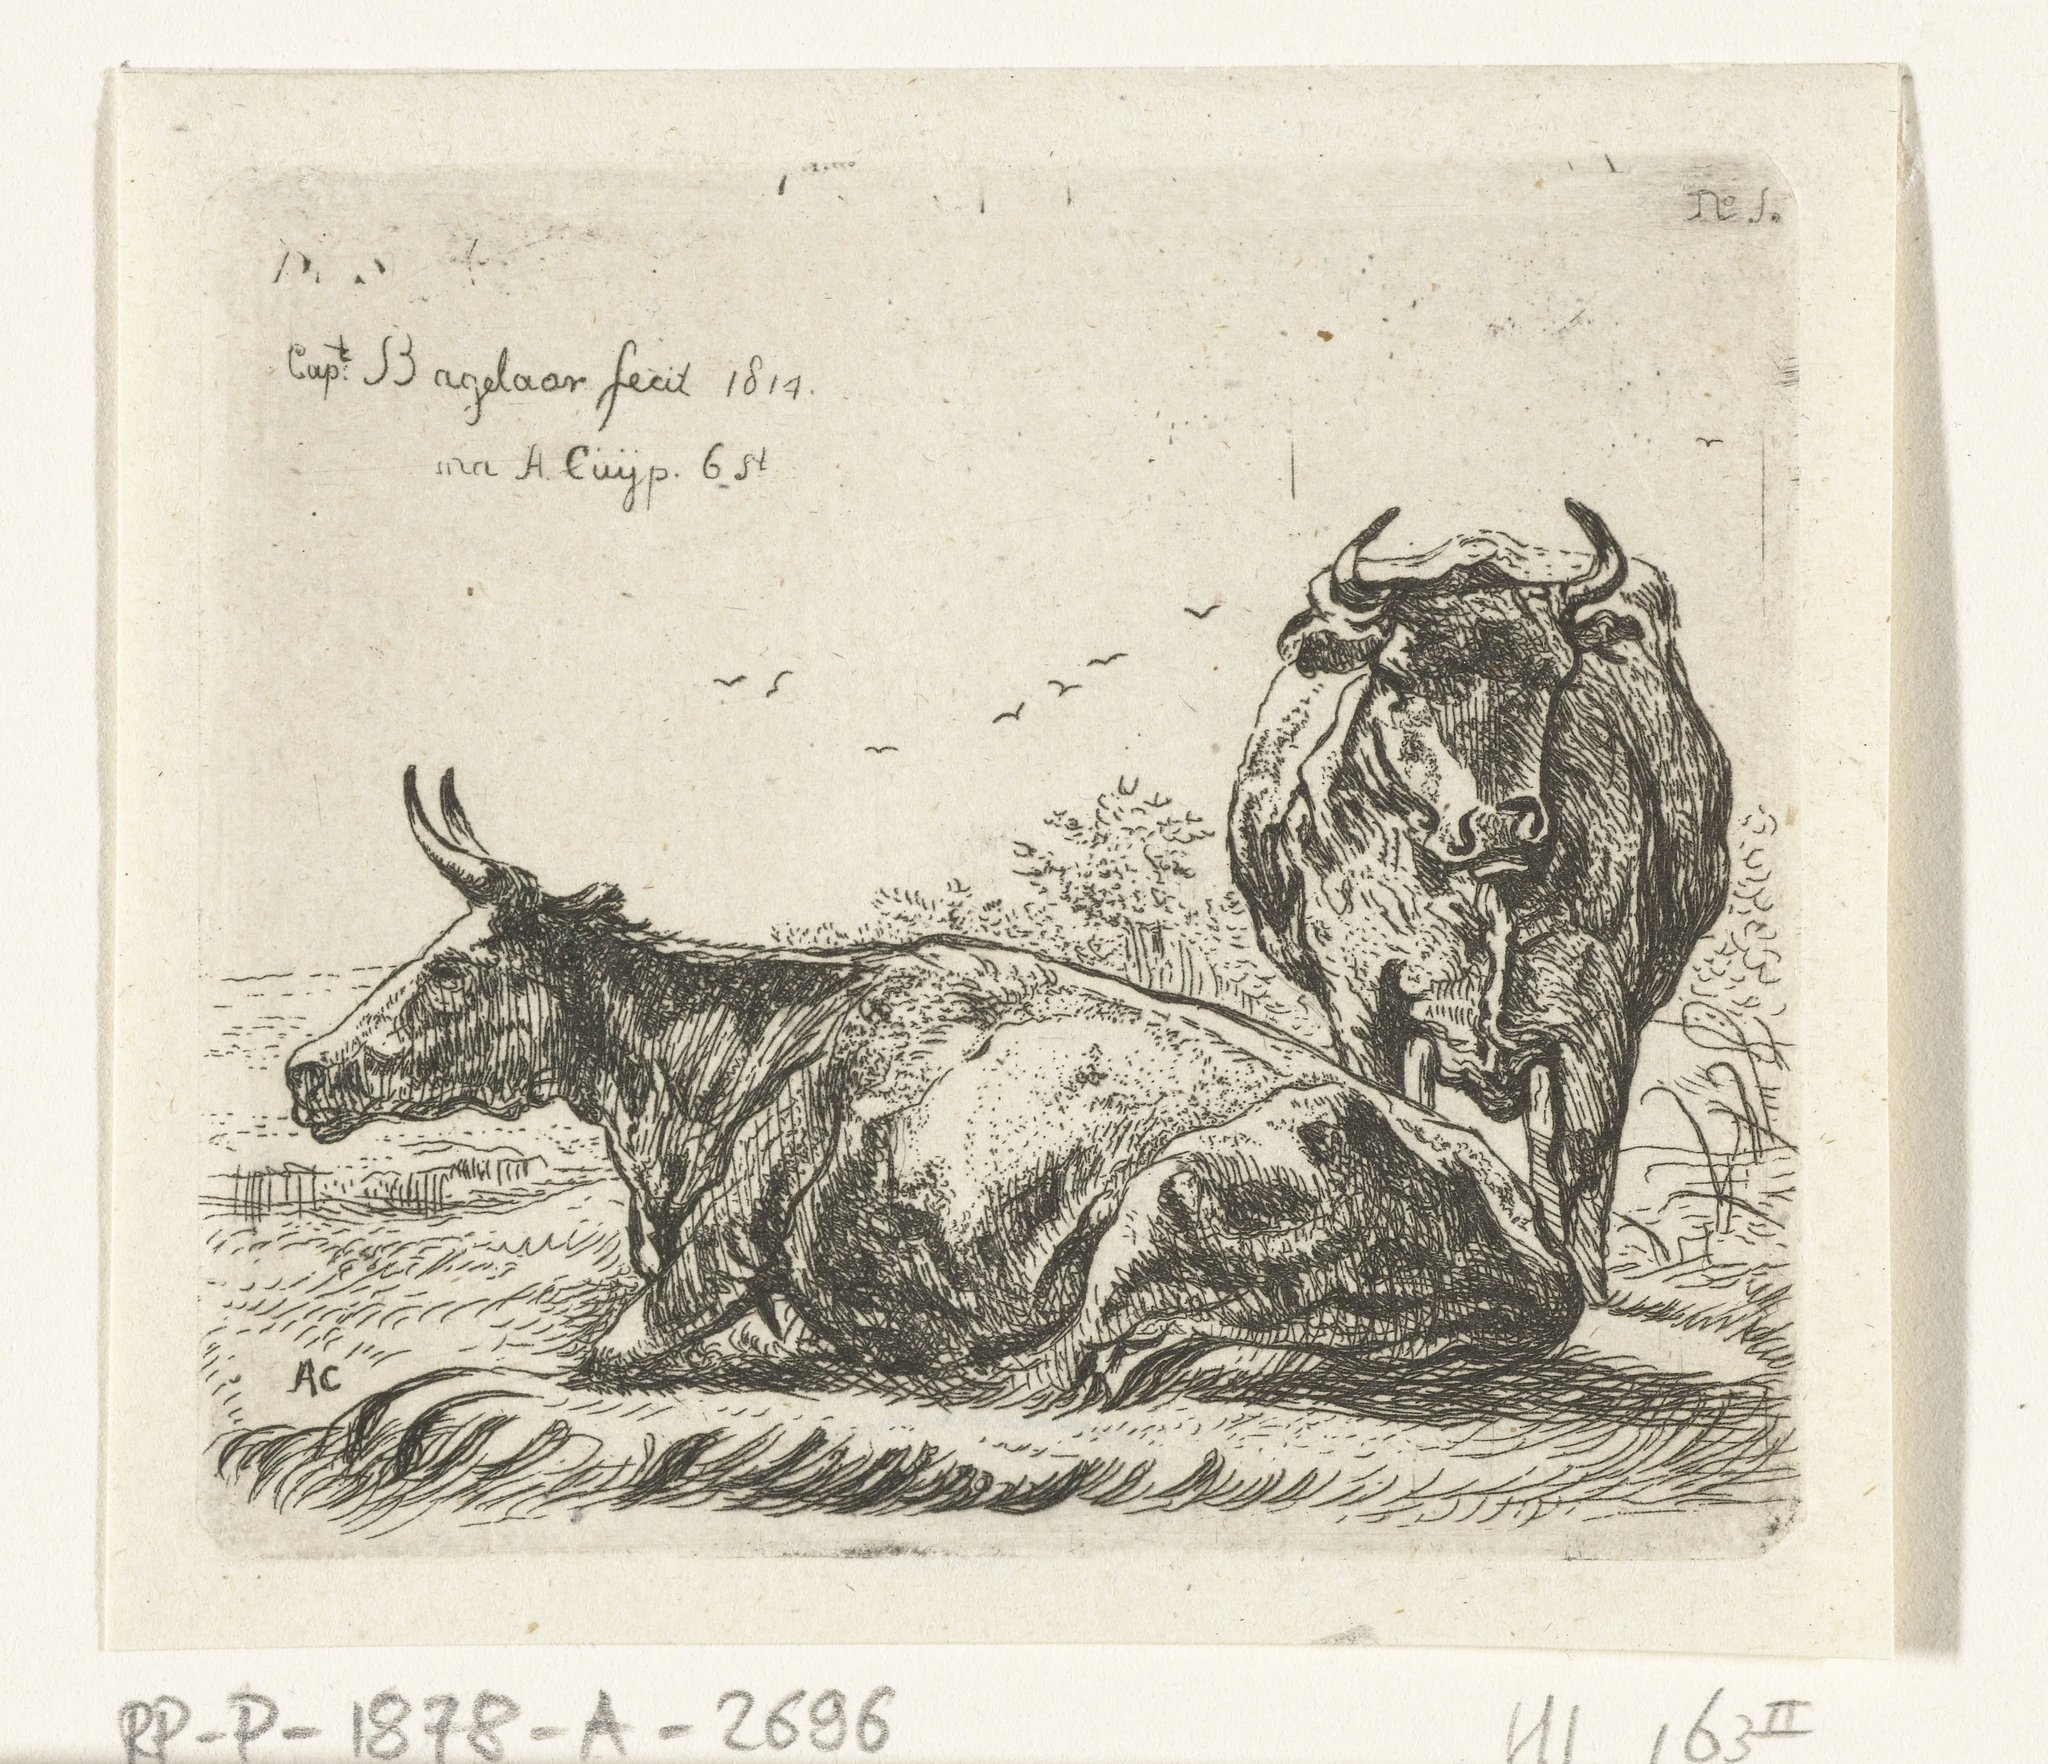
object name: print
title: Liggende en staande koe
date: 1814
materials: paper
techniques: etching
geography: netherlands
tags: cow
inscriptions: collector's mark: Lugt 2228